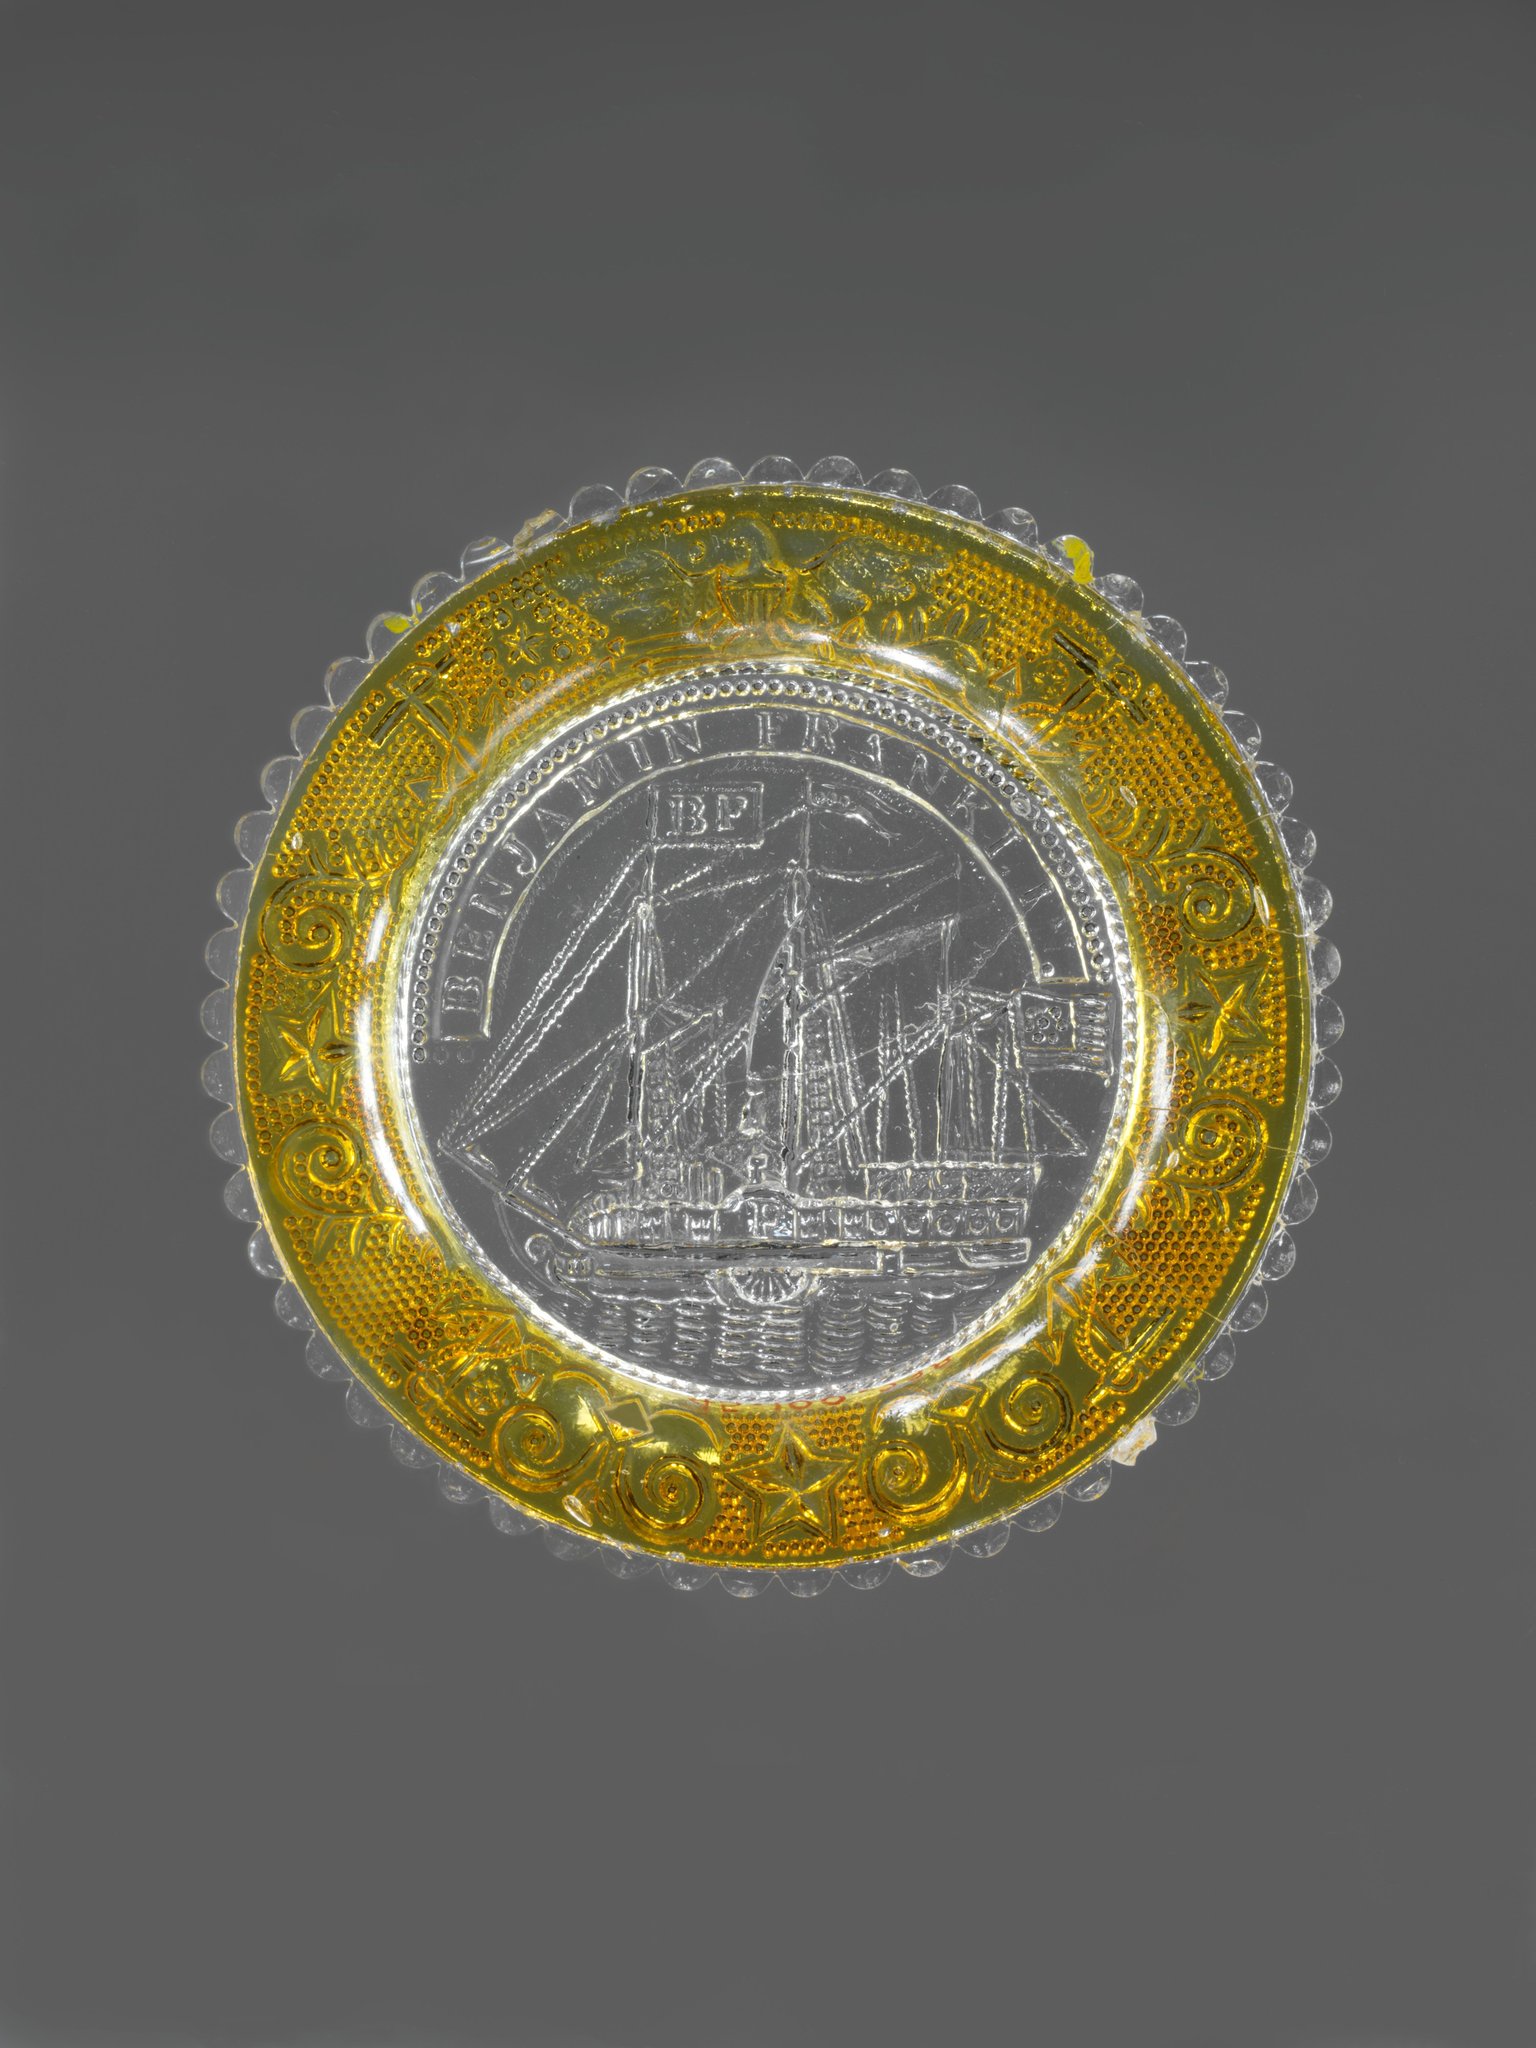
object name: cup plate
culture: american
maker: boston & sandwich glass company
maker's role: maker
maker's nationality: american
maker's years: 1825-1888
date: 1829-1840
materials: glass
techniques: pressed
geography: united states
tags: ships